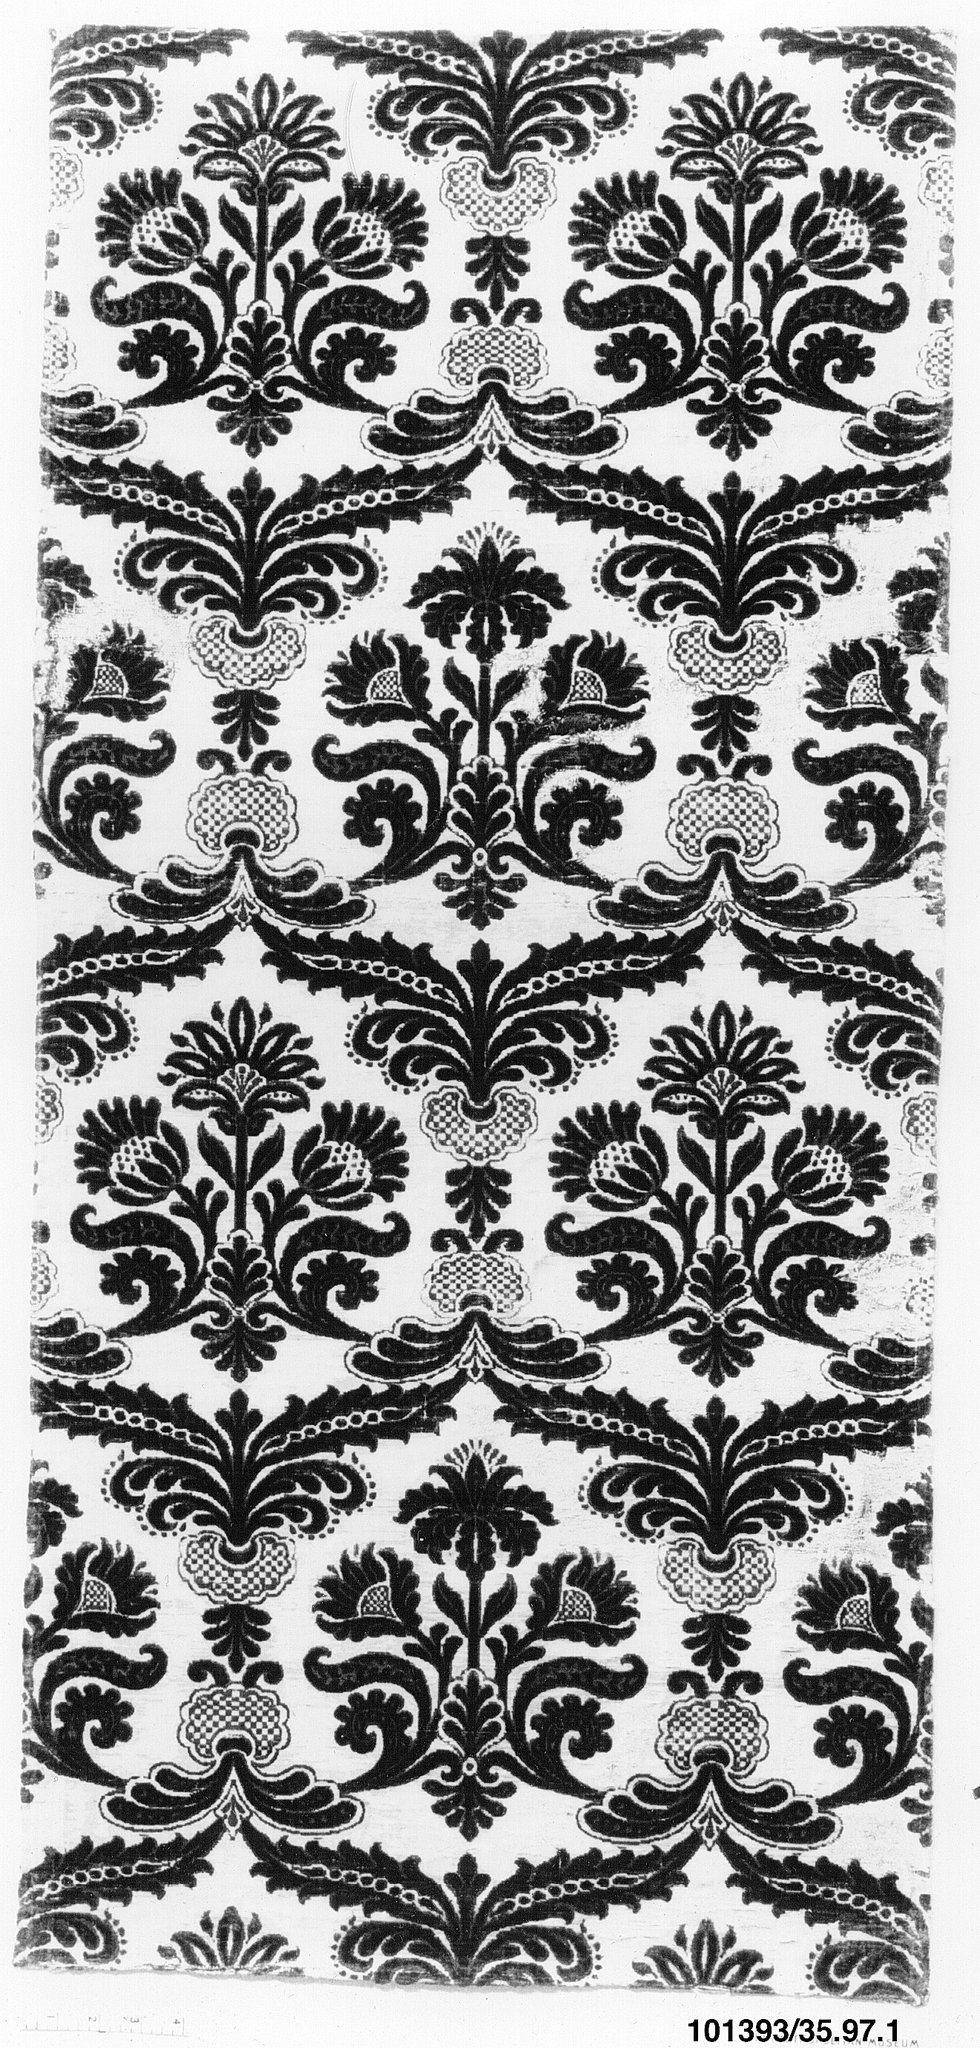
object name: piece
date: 1551-1600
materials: metal thread, silk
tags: flowers,leaves